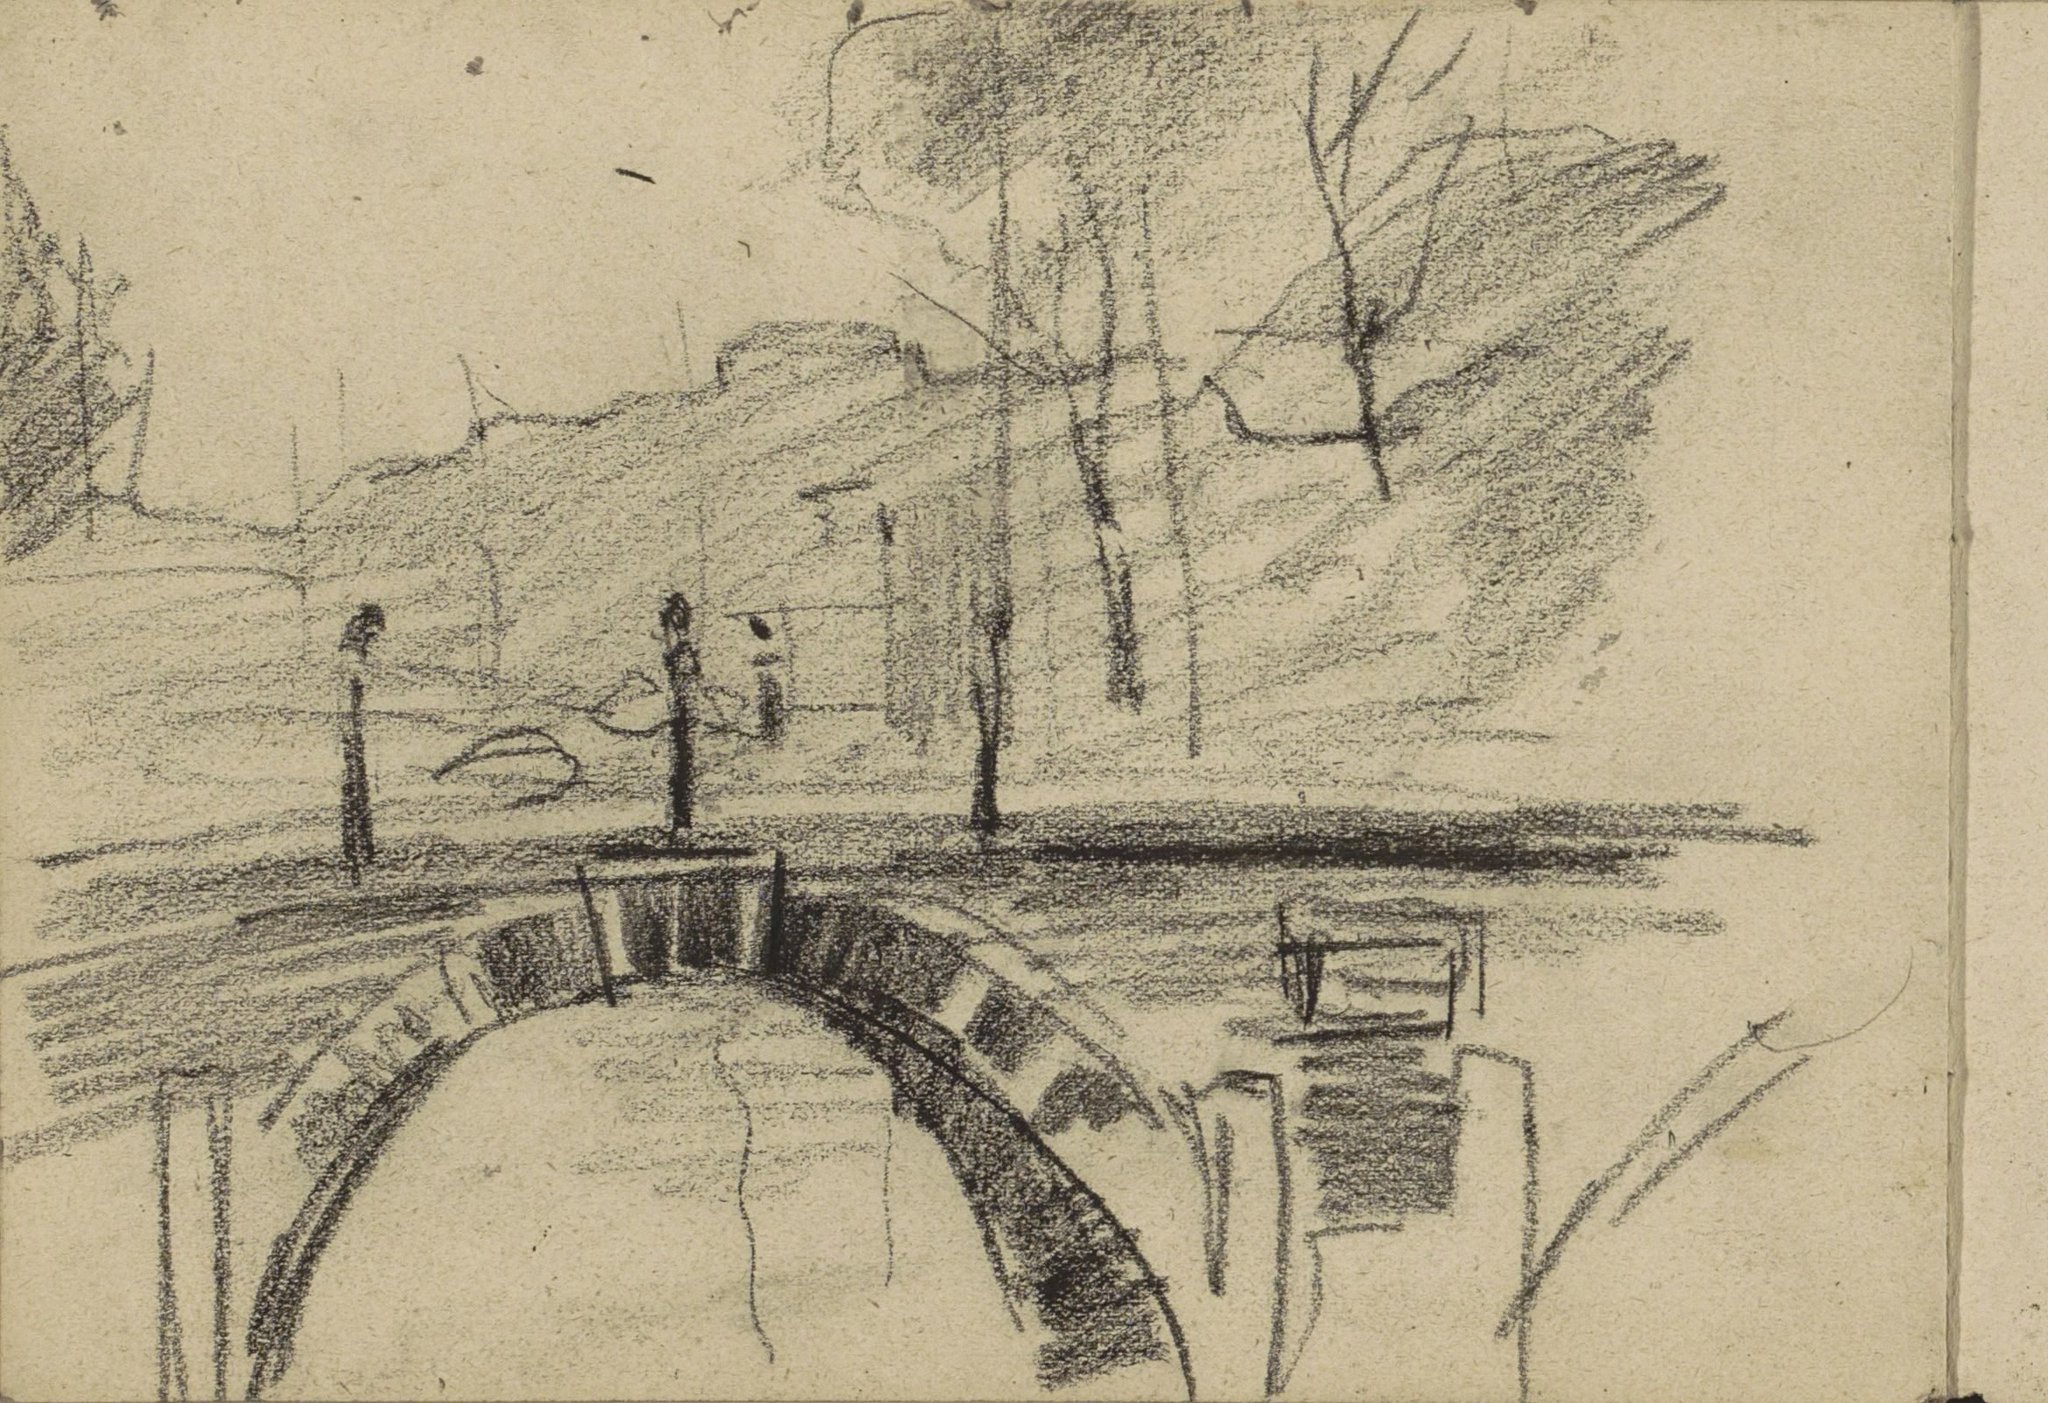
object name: sketchbook leaf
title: Gezicht op de brug Lekkeresluis te Amsterdam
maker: willem witsen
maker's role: draughtsman, painter, print maker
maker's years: 1860-1923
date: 1903-1904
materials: chalk, paper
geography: amsterdam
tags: bridge in city across river, canal, etc.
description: Pagina 26 uit een schetsboek met 16 bladen.